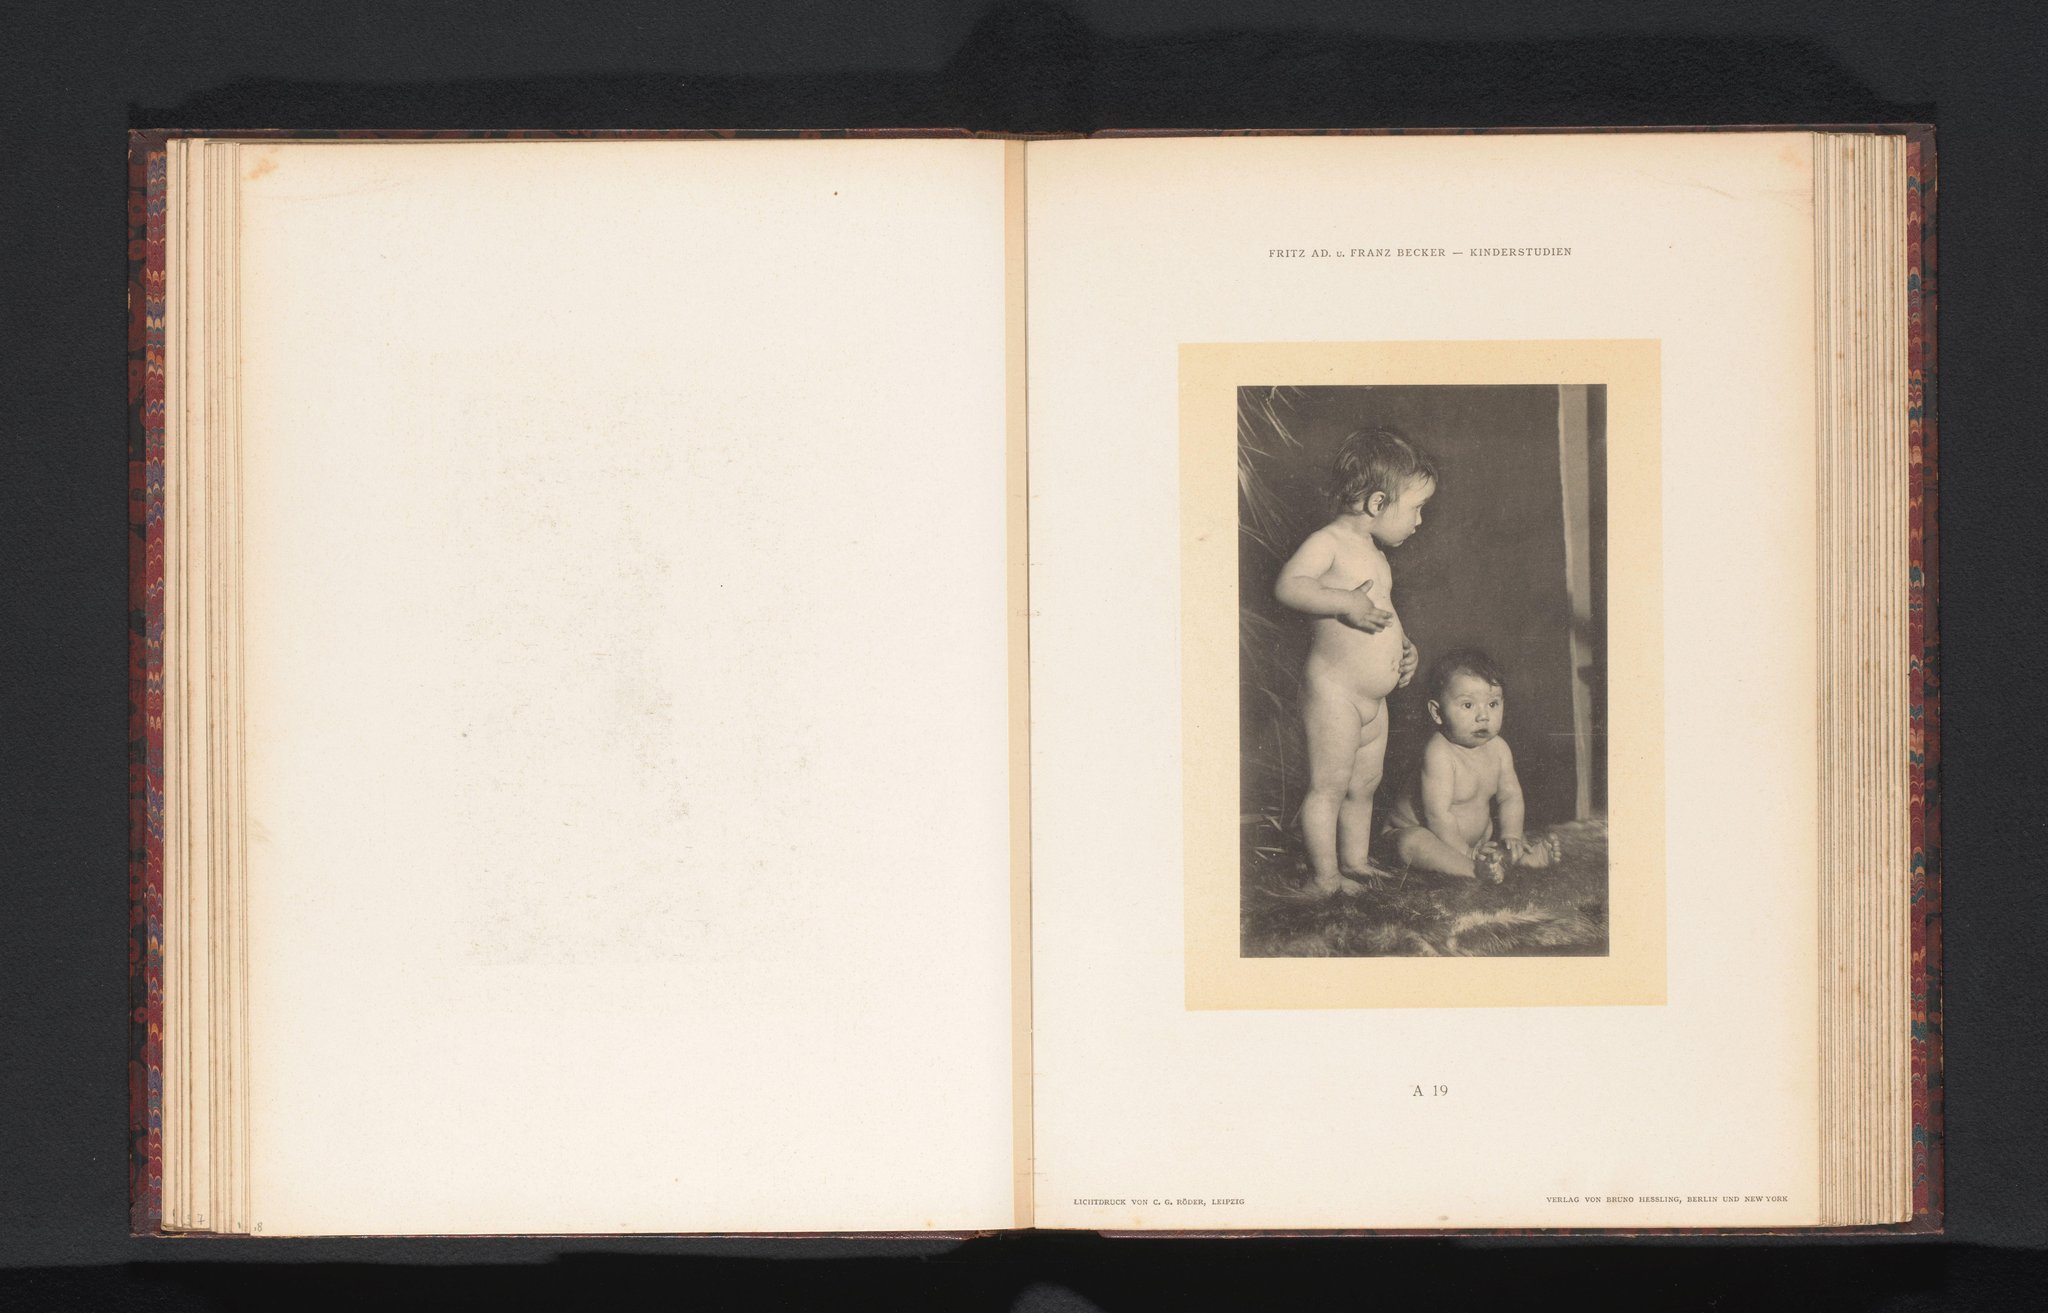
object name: photomechanical print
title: Twee naakte kinderen, één staand en één zittend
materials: paper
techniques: photograph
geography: berlin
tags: standing figure (+ sideview, profile), sitting on the ground, tot, toddler ~ the ages of man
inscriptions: number: ‘A 19’